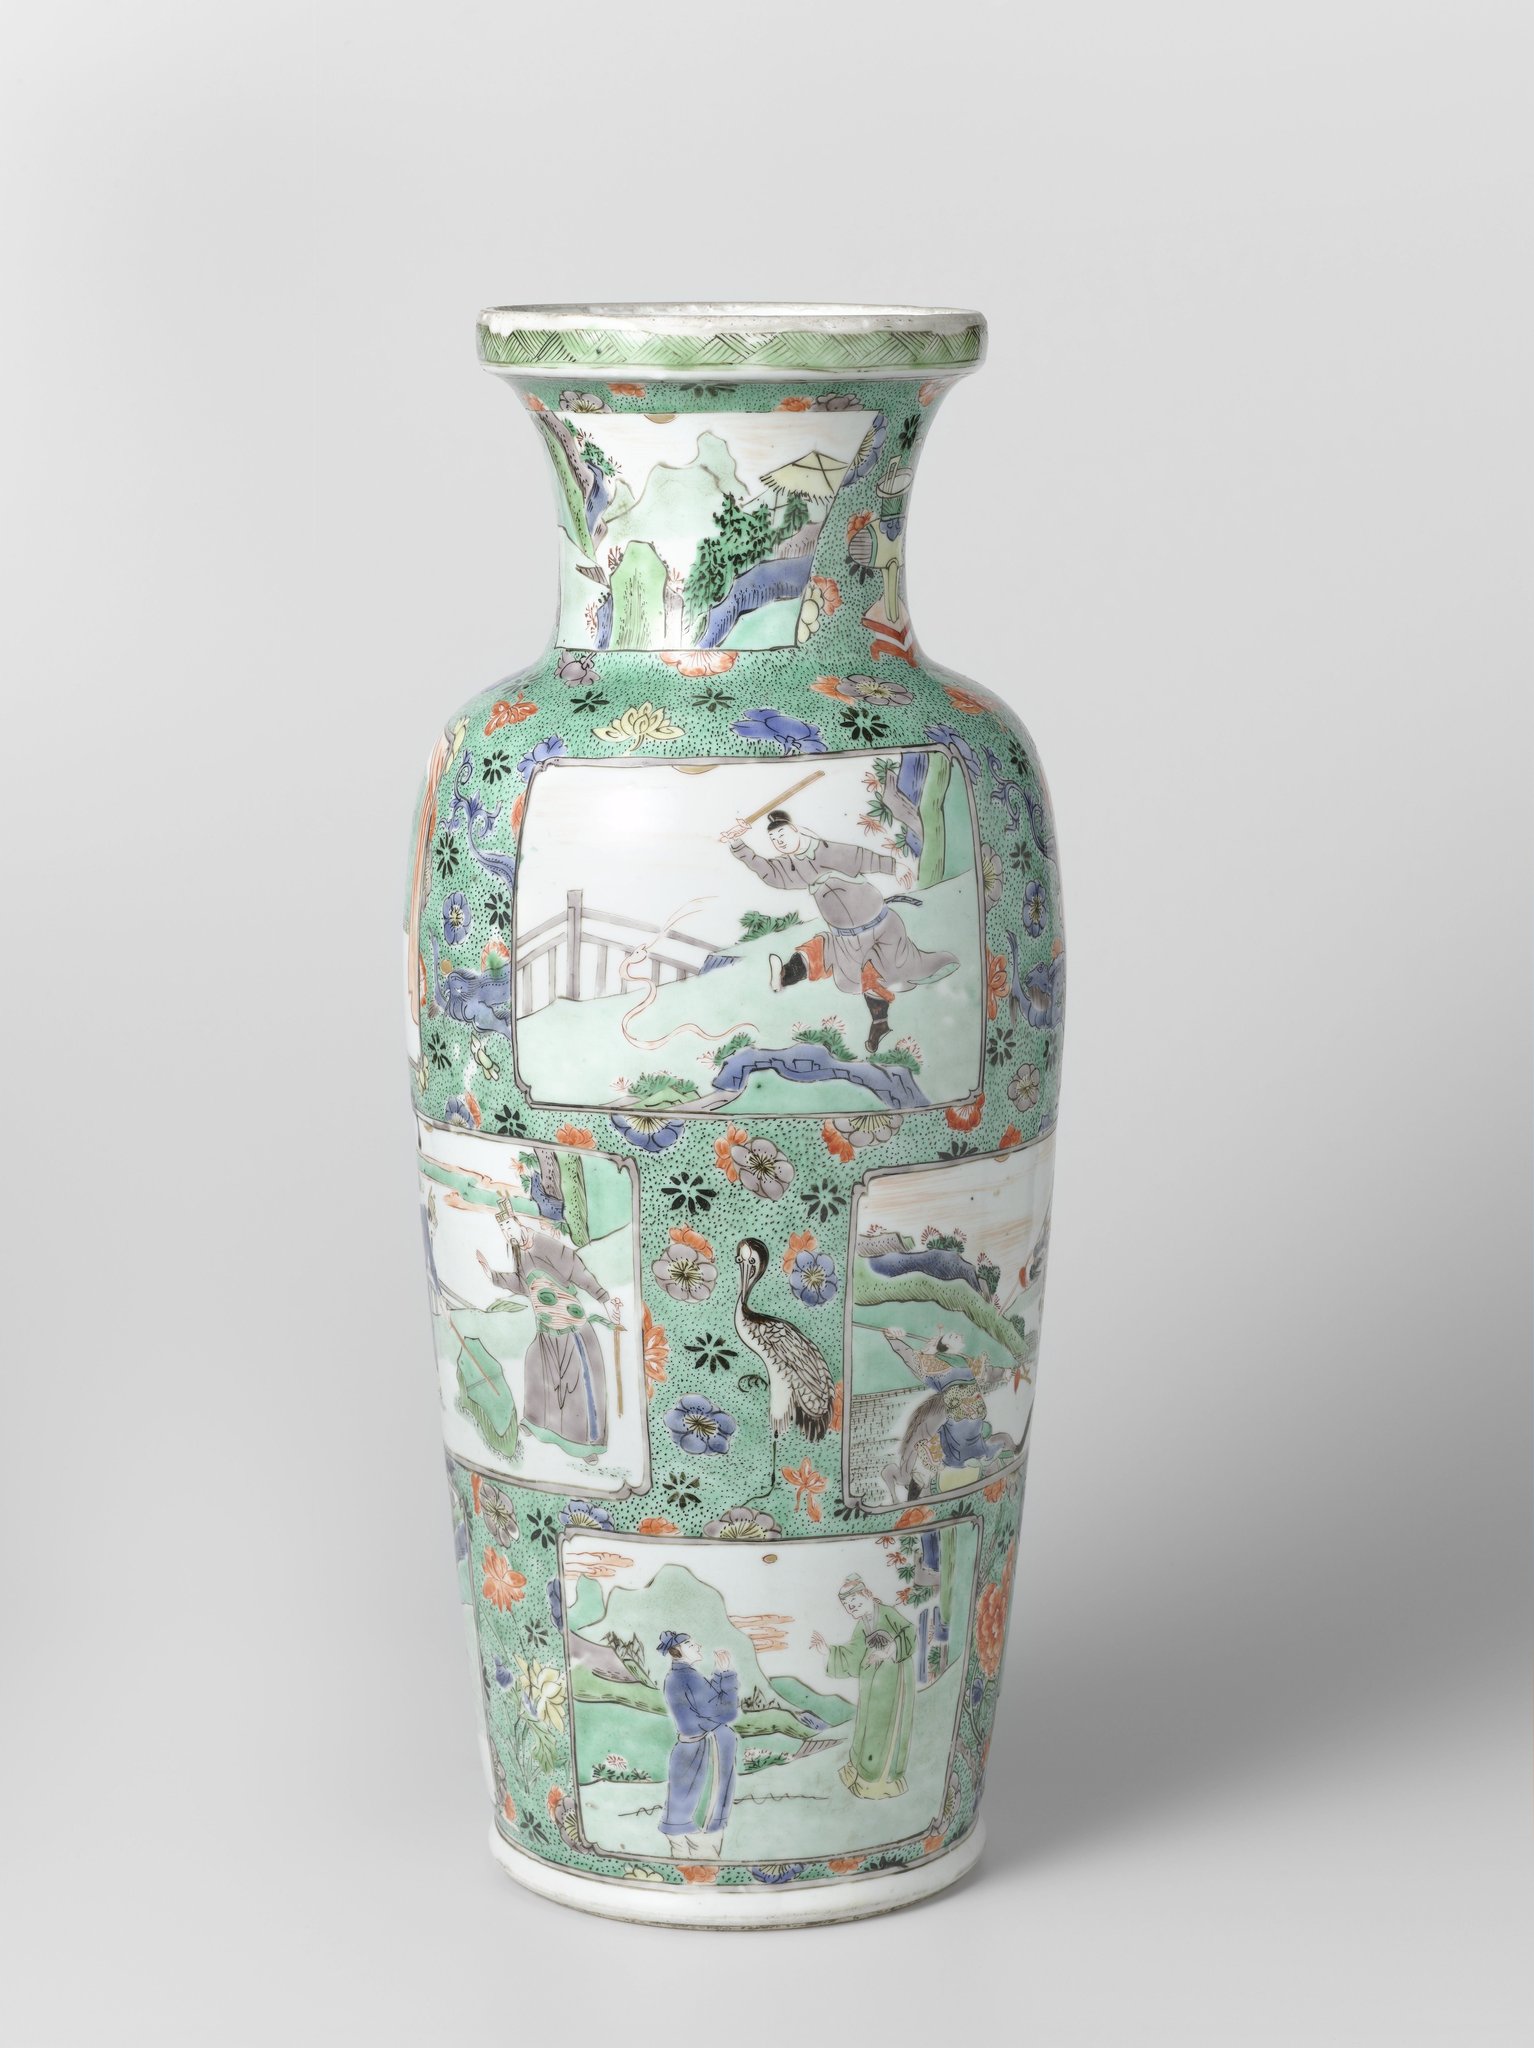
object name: rolwagen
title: Rolwagen vase with figural scenes in panel decoration against a green ground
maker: Anonymous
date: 1700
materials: glaze, gold, paint, porcelain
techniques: firing, gilding, turning, vitrification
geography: china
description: Vase. China. Kangxi period, 1662 - 1722. Porcelain, colours over the glaze.